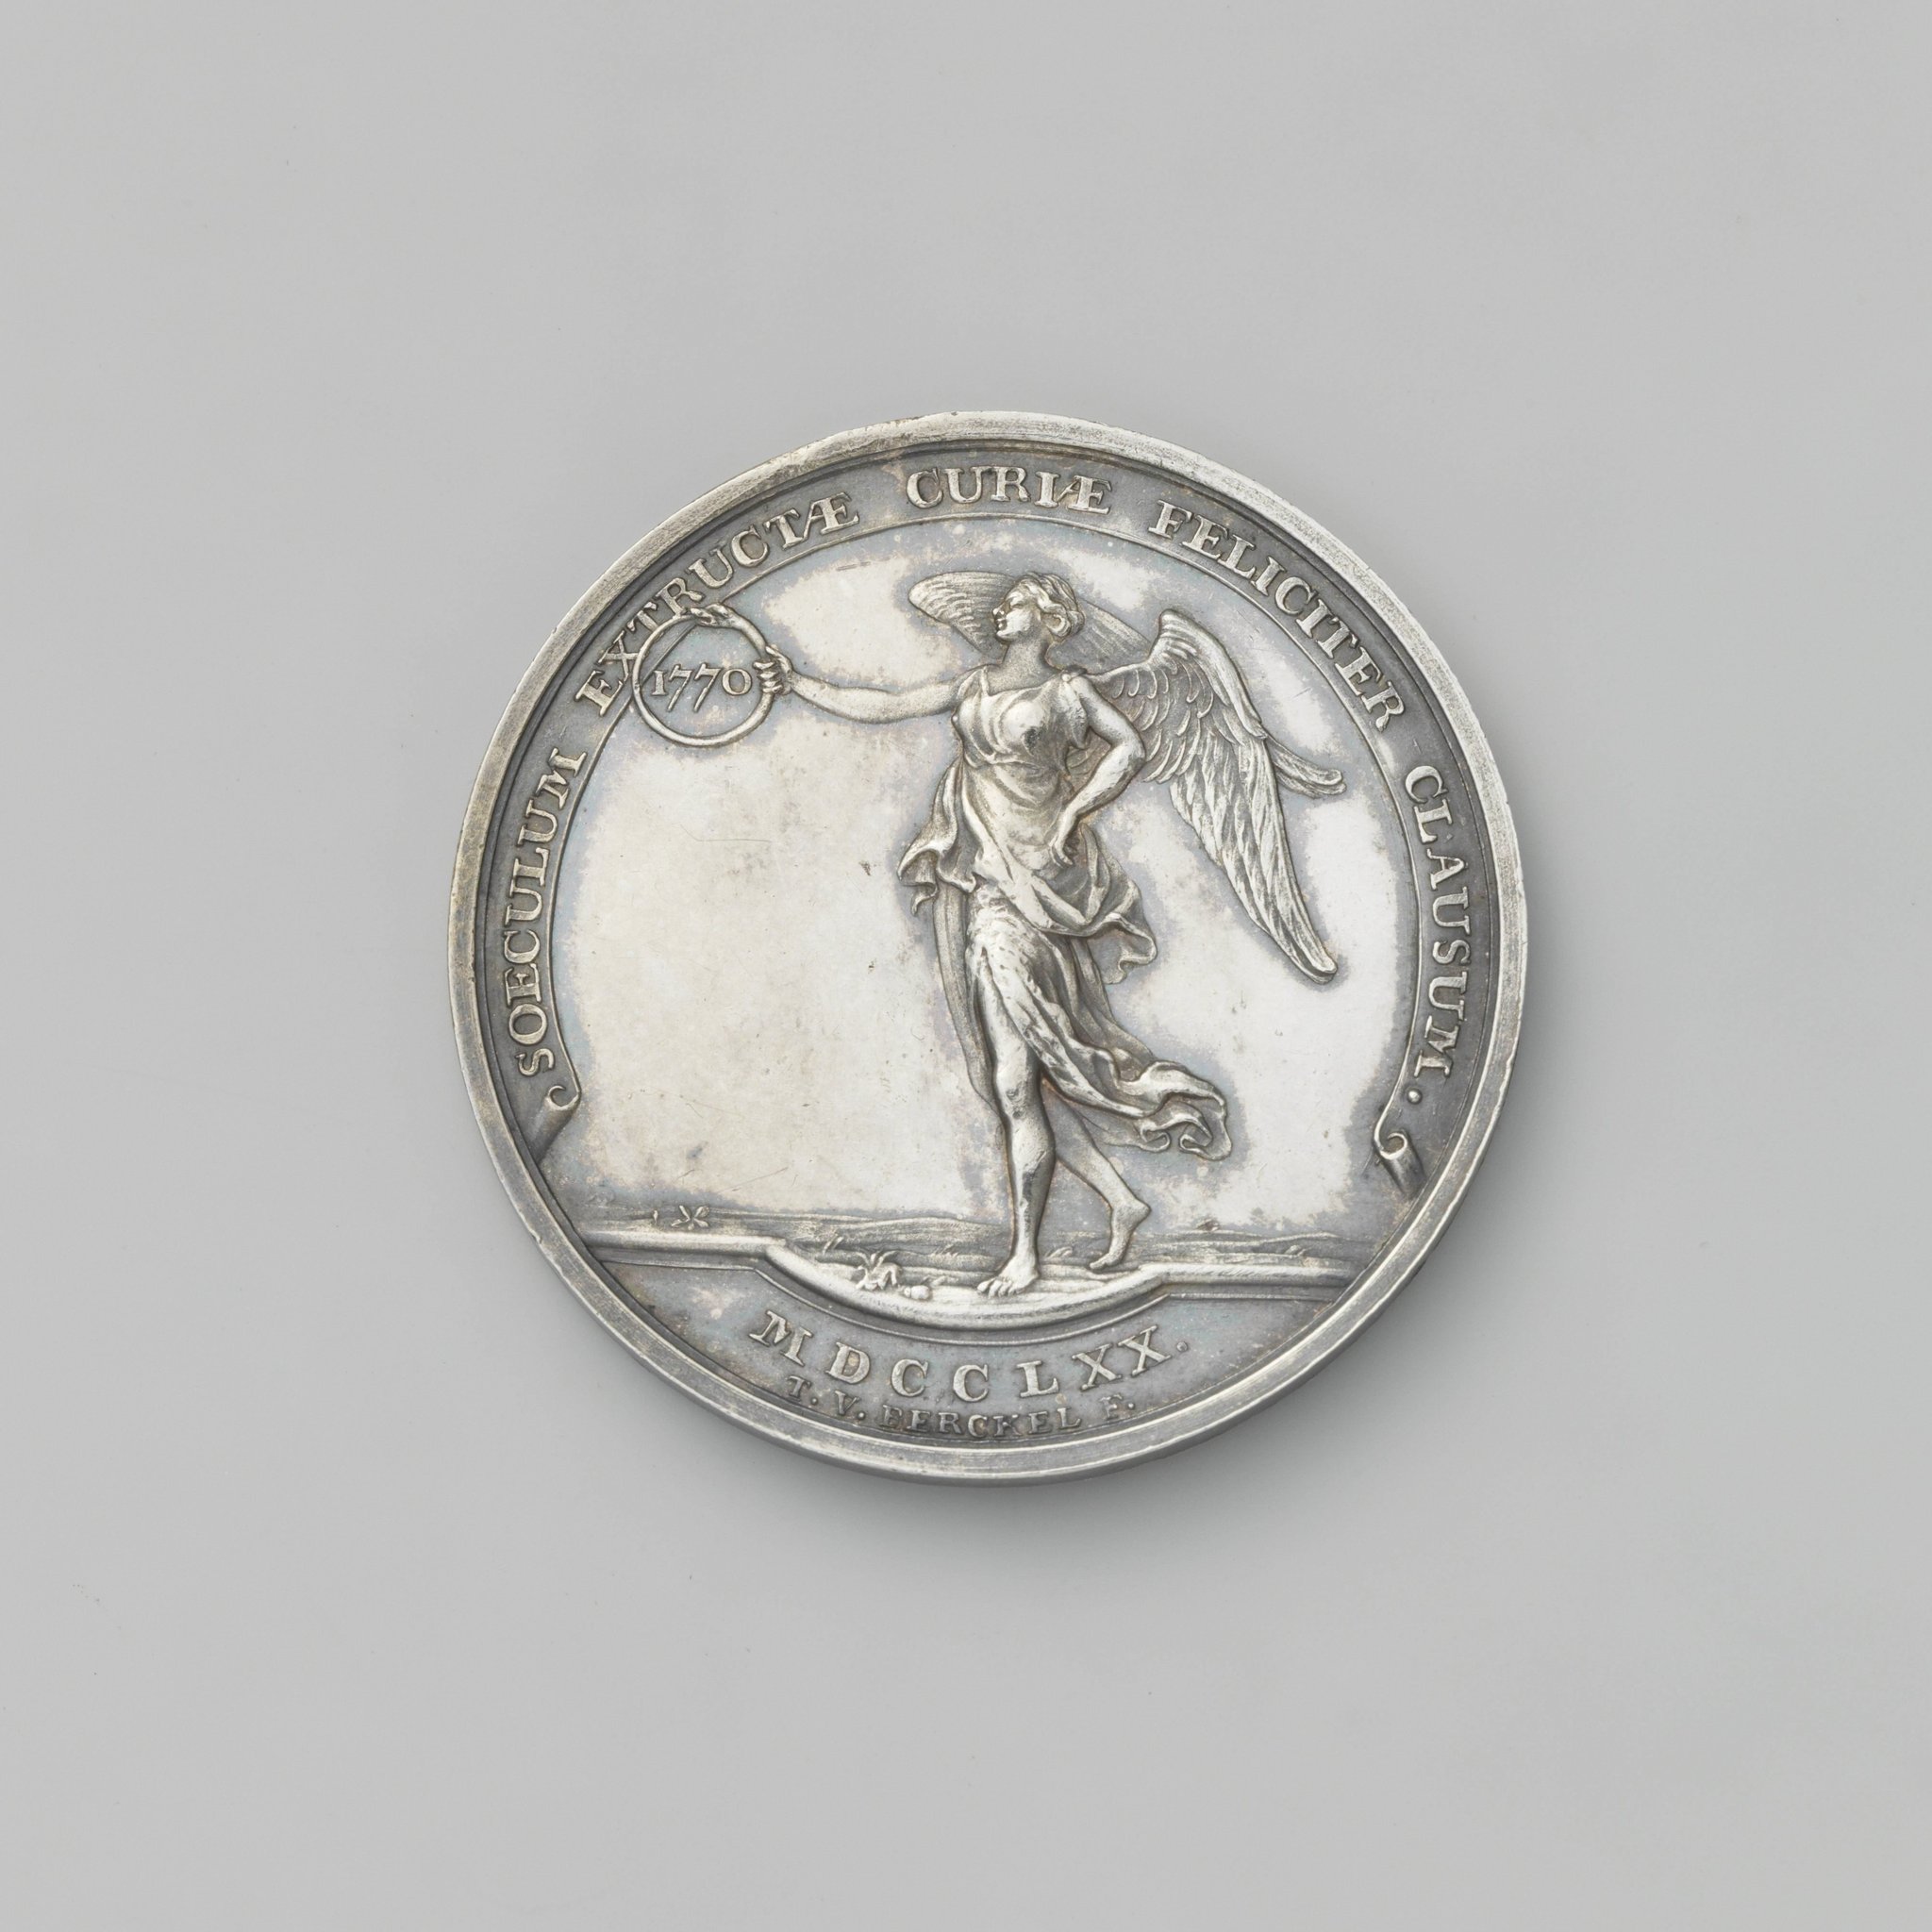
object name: council medal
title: 's-Hertogenbosch, vroedschapspenning op het eeuwfeest van de herbouwing van het stadhuis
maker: theodorus victor van berckel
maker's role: mintmaster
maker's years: 1739-1808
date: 1770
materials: silver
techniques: striking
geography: den bosch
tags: den bosch